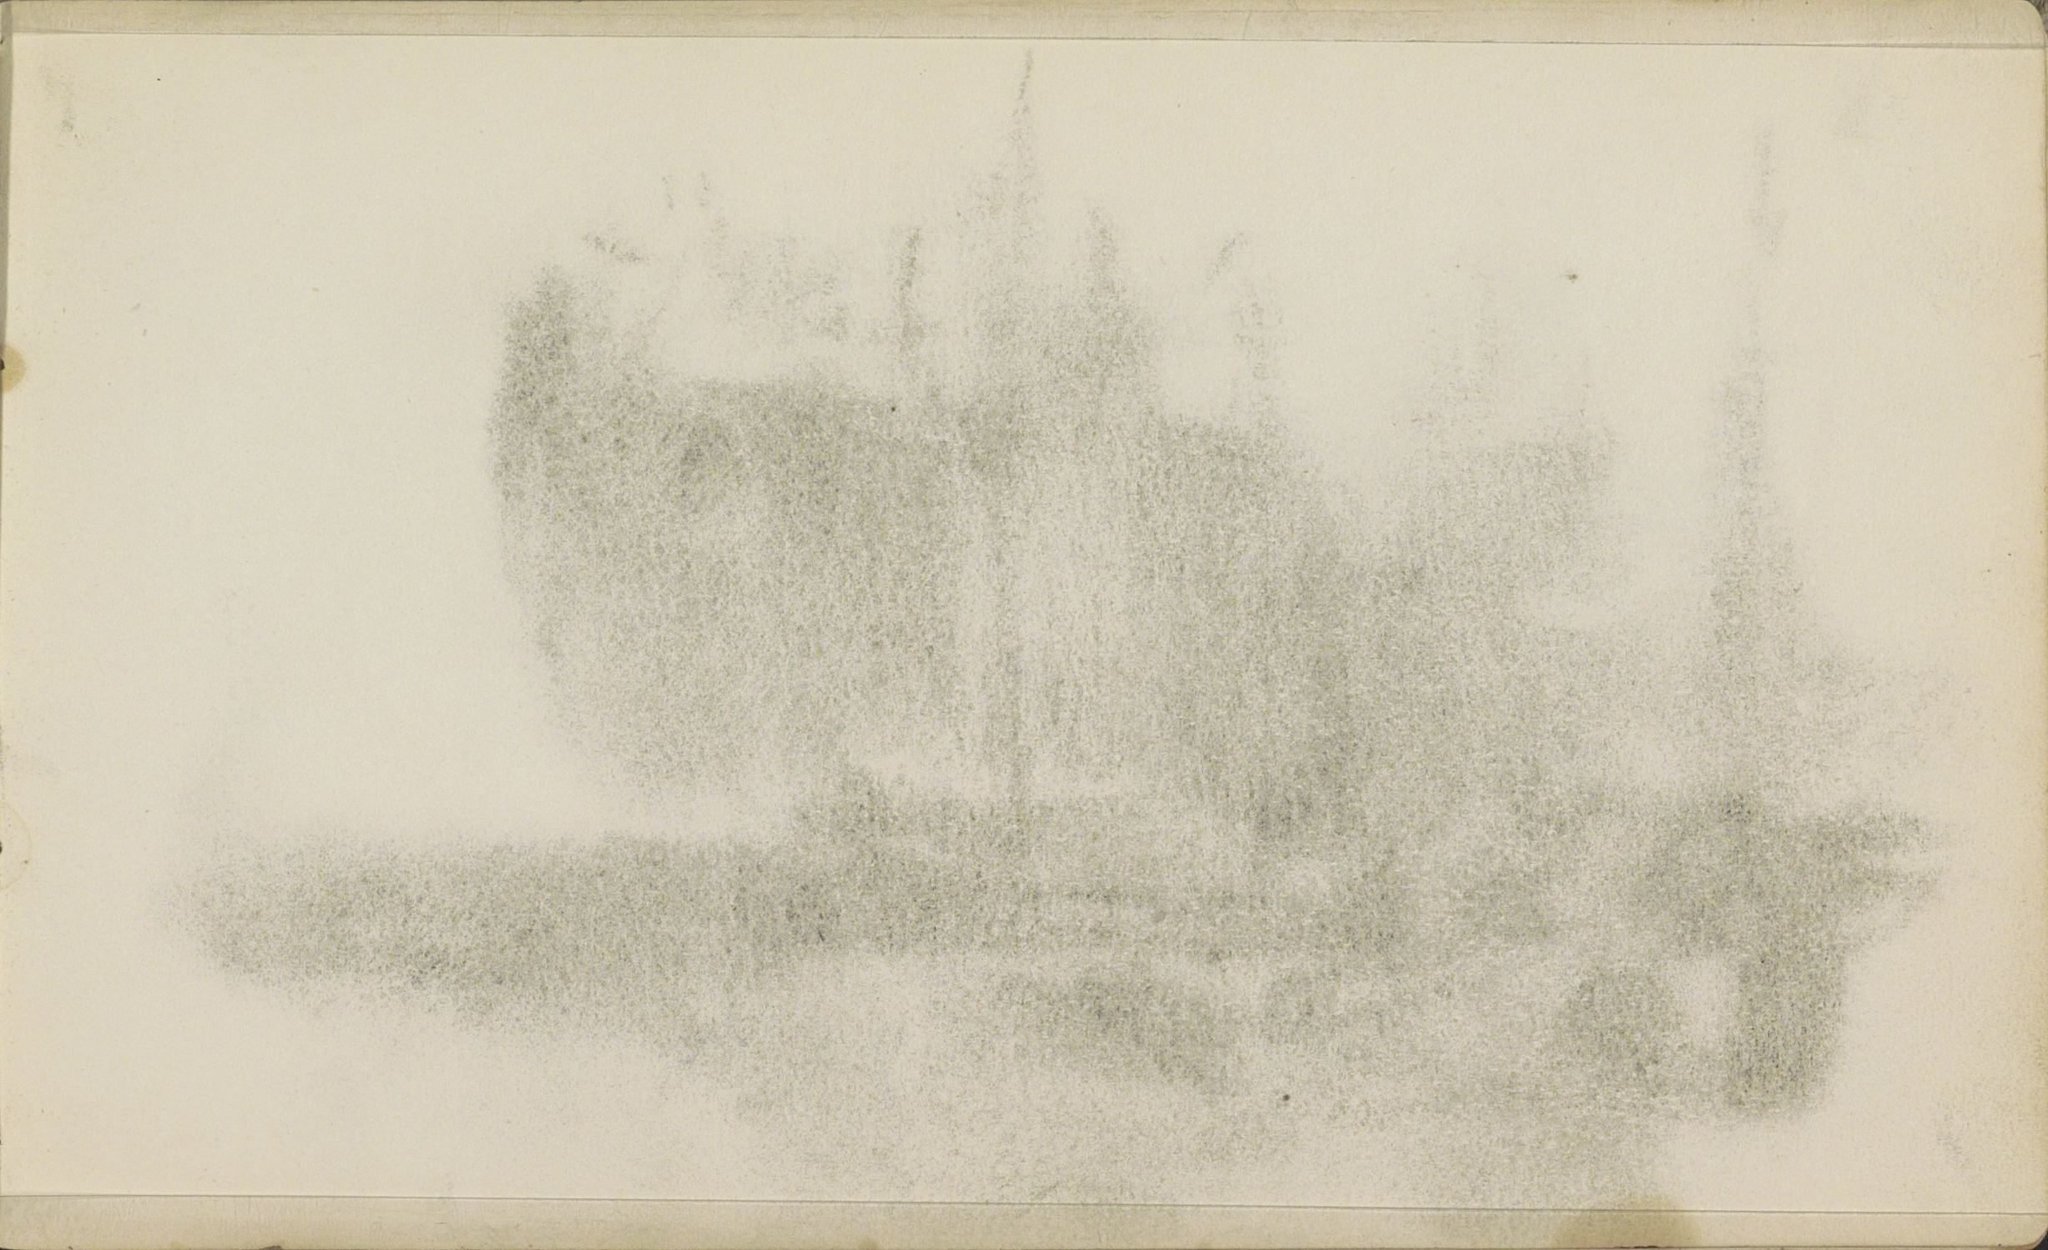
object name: sketchbook leaf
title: Havengezicht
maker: jozef israëls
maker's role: draughtsman, painter, print maker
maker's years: 1824-1911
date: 1834-1911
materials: paper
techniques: printmaking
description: Blad 35 recto uit een schetsboek met 42 bladen.